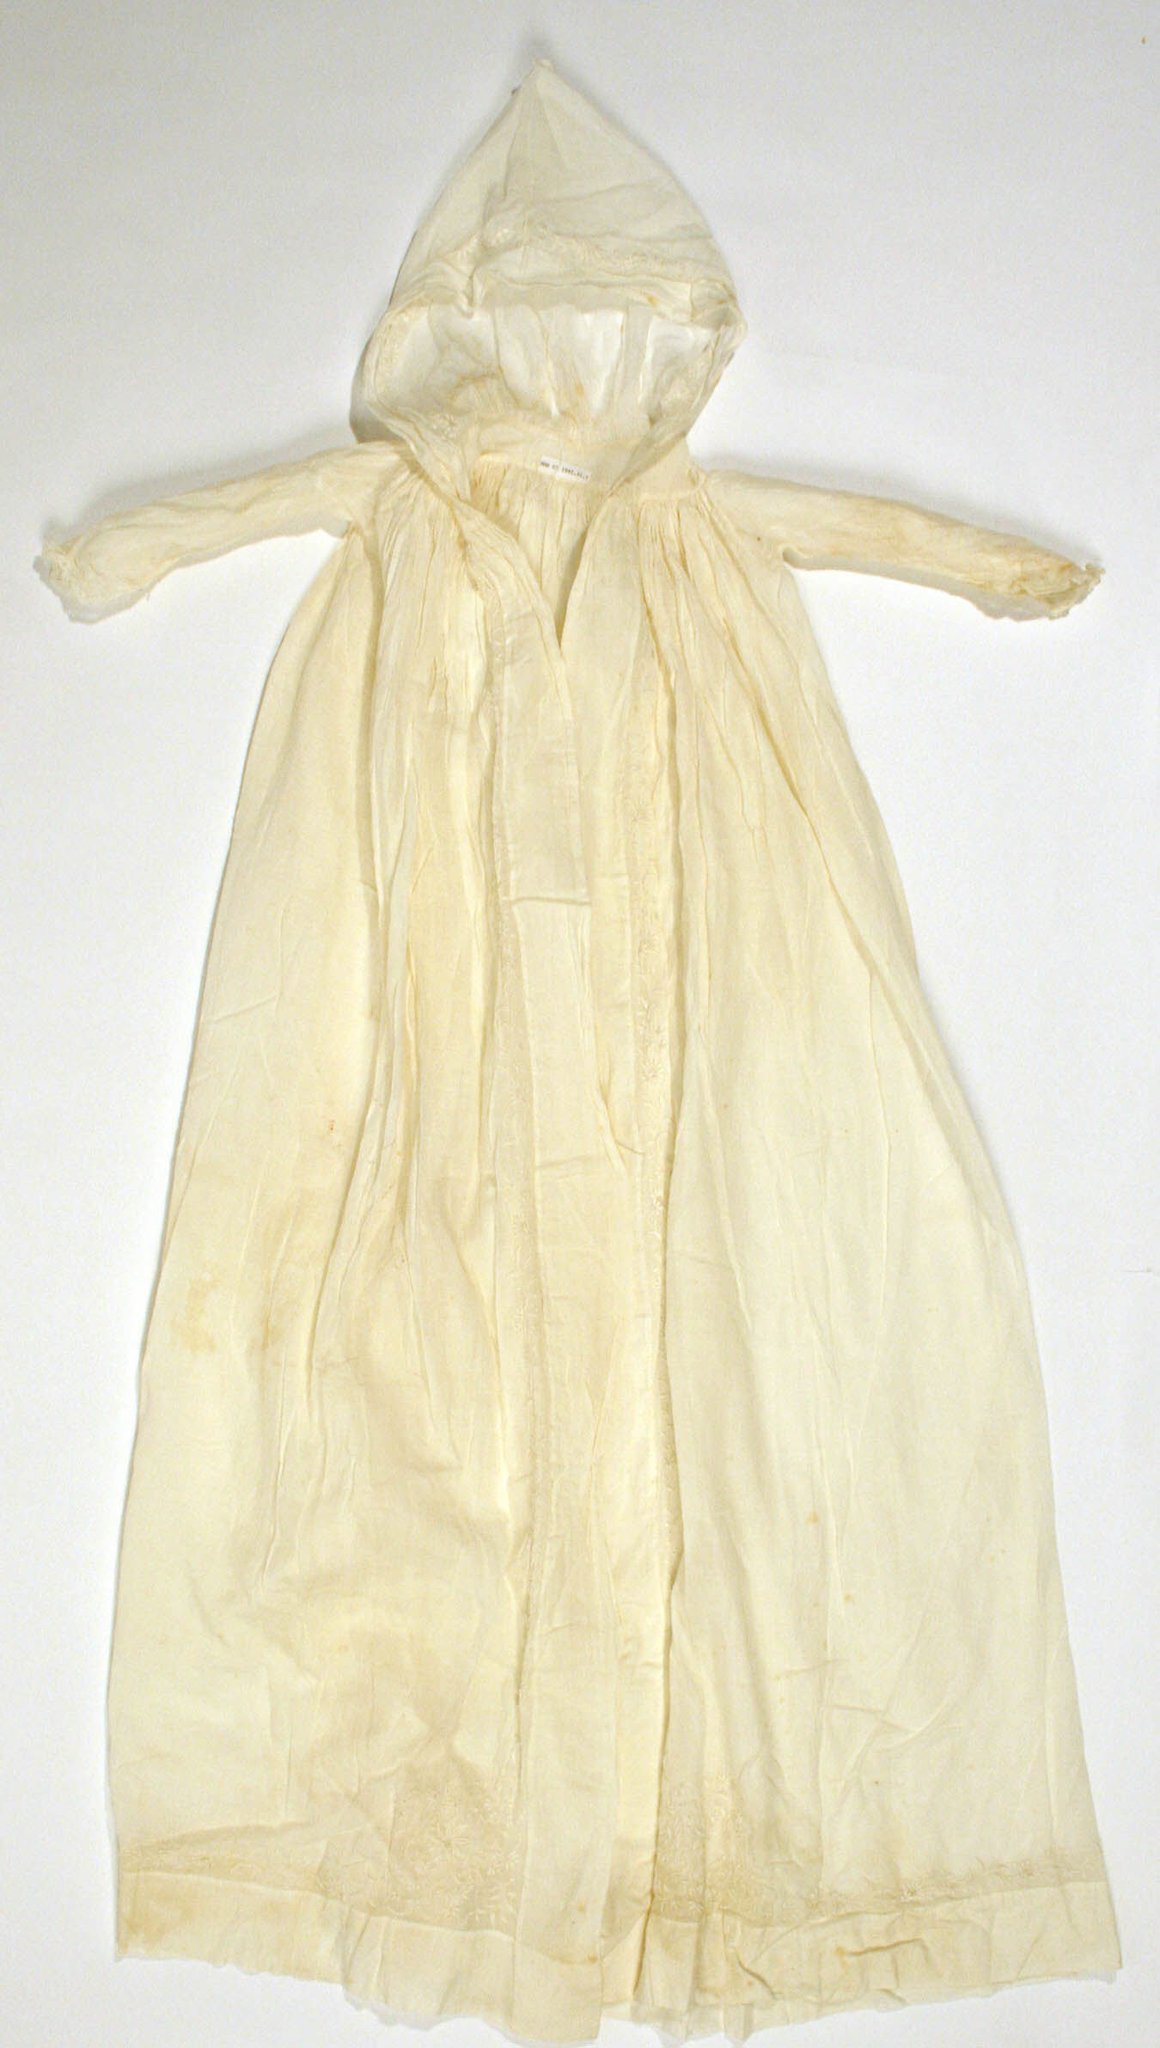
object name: coat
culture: american or european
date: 1801-1900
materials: cotton